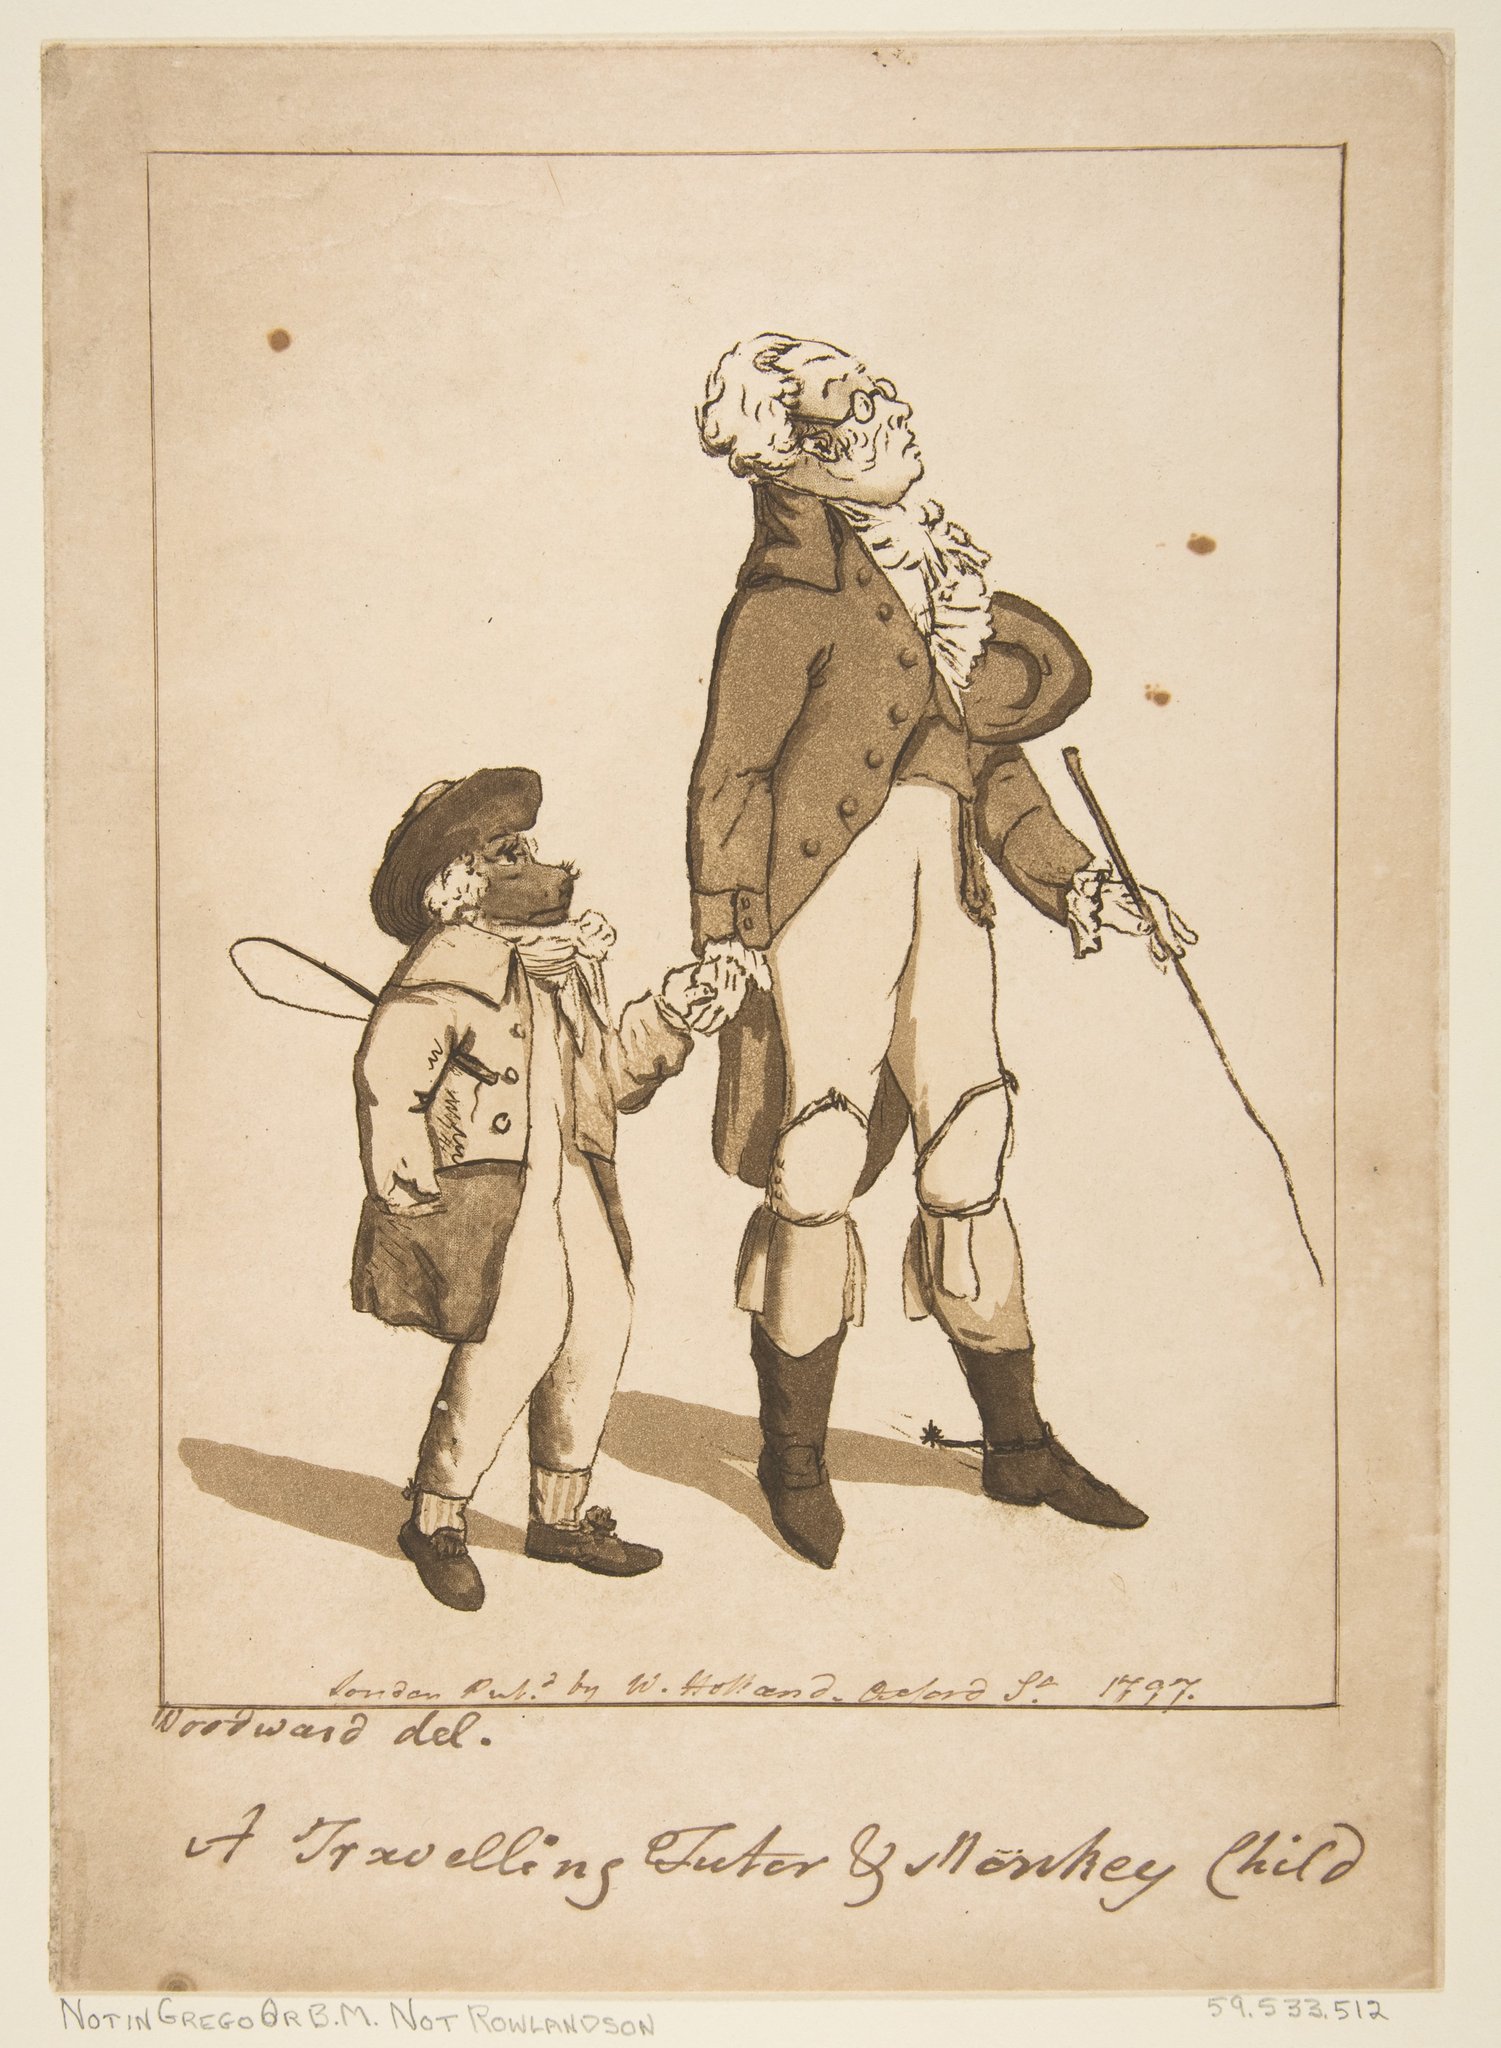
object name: print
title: A Travelling Tutor and Monkey Child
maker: george murgatroyd woodward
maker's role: artist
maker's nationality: british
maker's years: 1765-1809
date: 1797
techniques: aquatint, etching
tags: human figures,satire